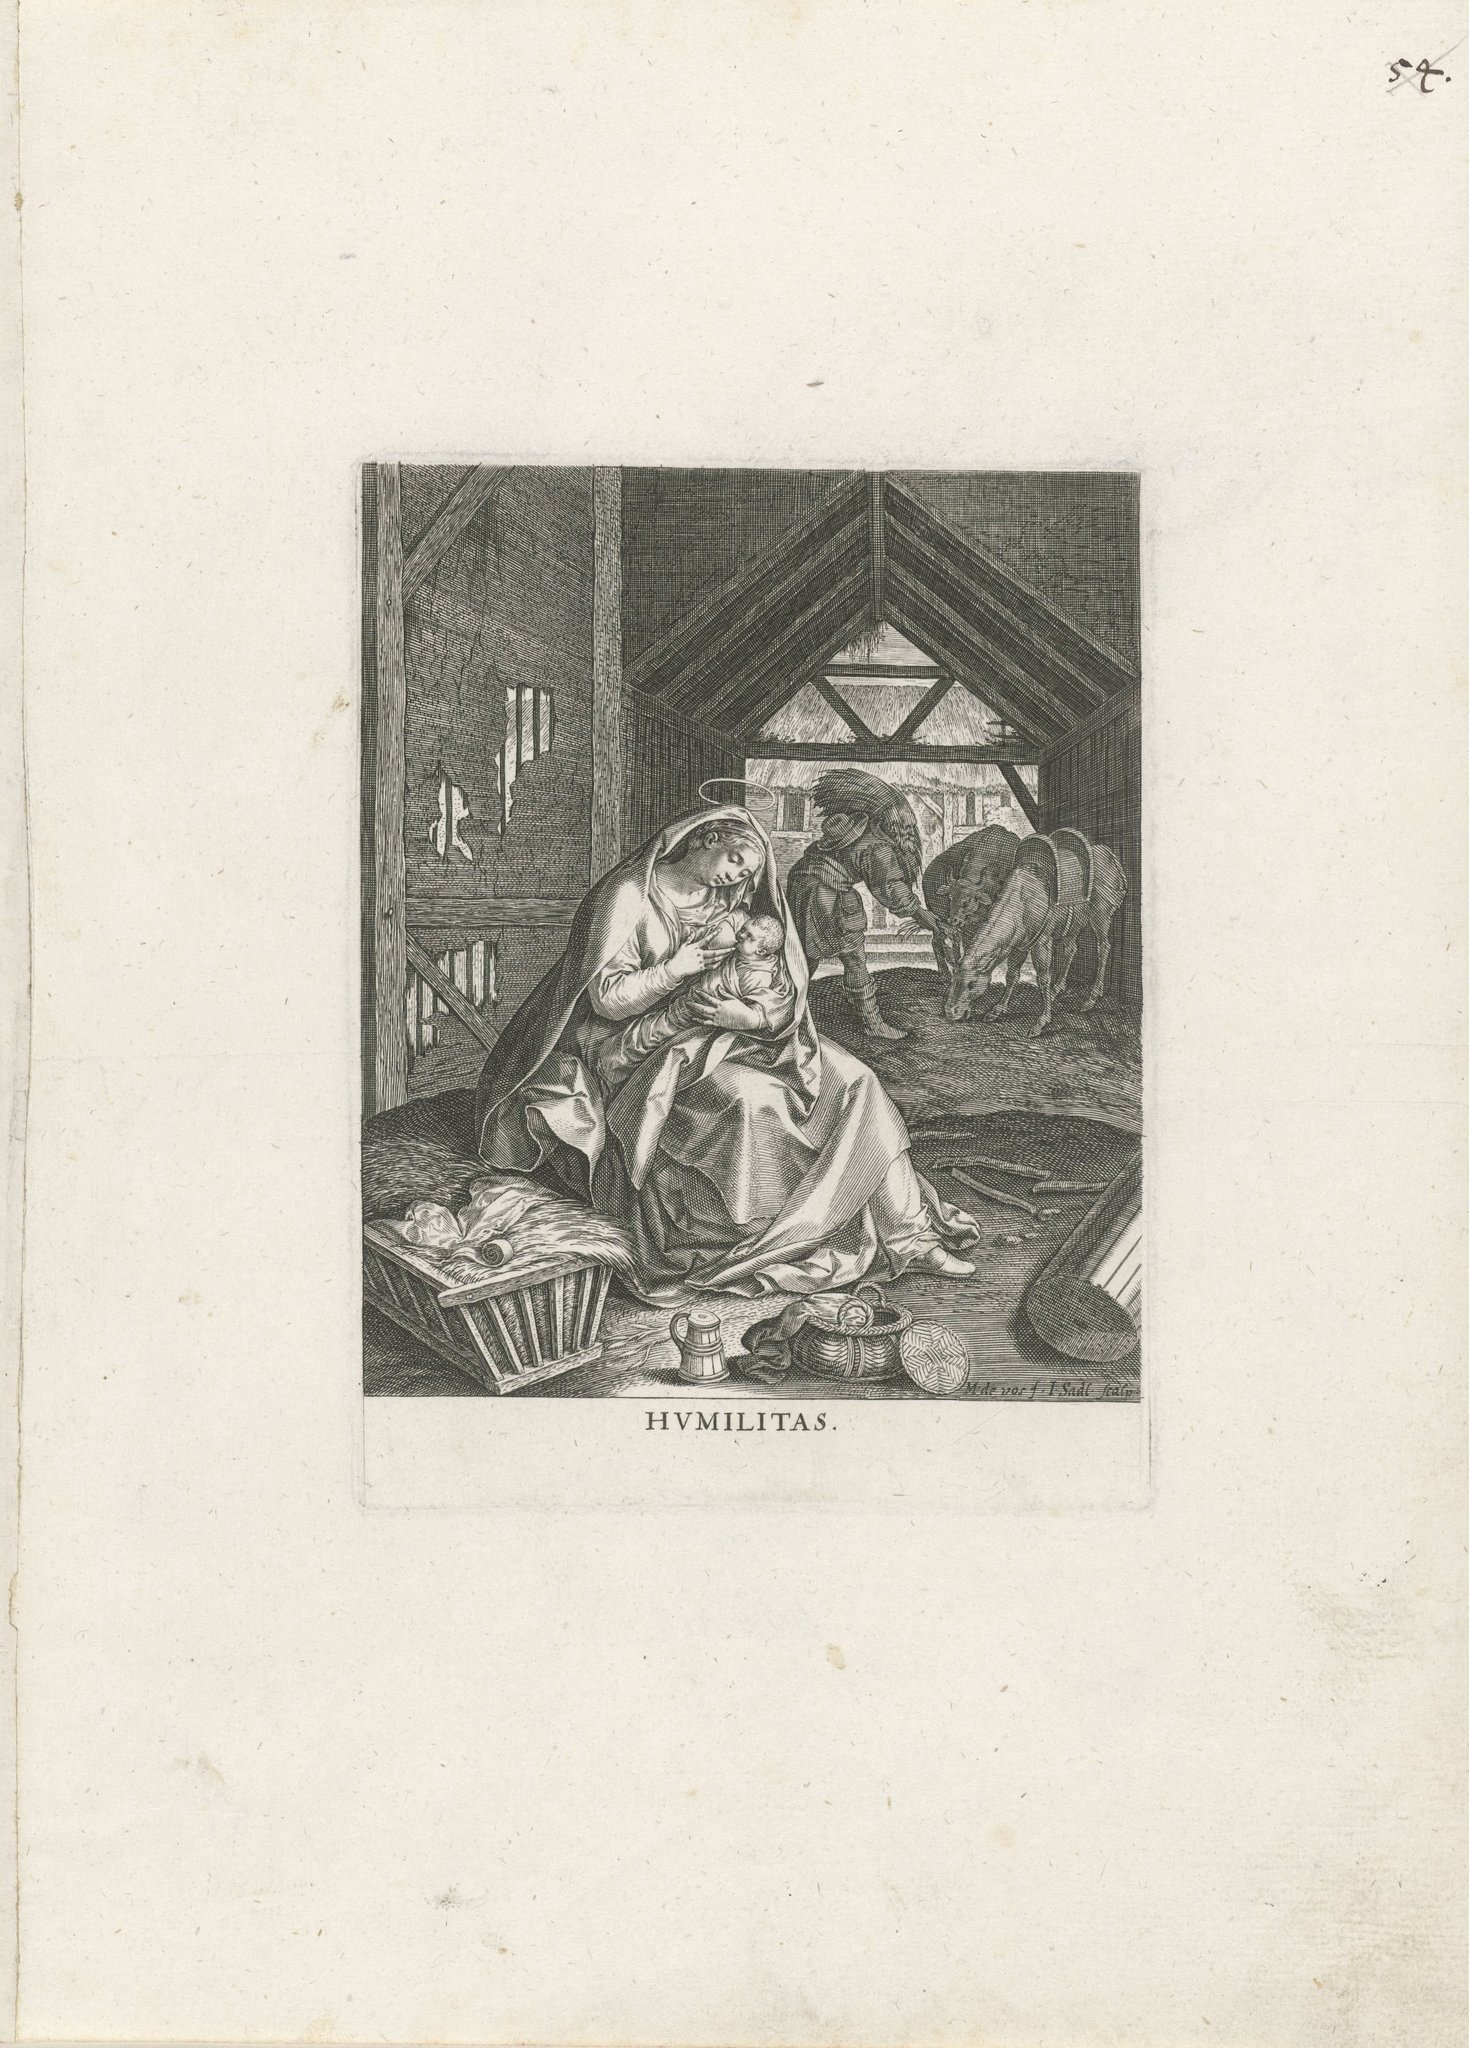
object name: print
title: Maria voedt het Christuskind: nederigheid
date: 1585-1588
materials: paper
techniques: engraving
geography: munich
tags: care of the new-born christ-child, e.g. swaddling, humility; 'humiltà' (ripa)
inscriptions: collector's mark: Lugt 2228, number: ‘53’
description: In eens tal geeft de maagd Maria het Christuskind de borst. Naast haar de kribbe. Op de achtergrond voedert Jozef de os en de ezel. De eerste prent van een achtdelige serie met scènes uit het leven van Christus die zijn belangrijkste deugden verbeelden.